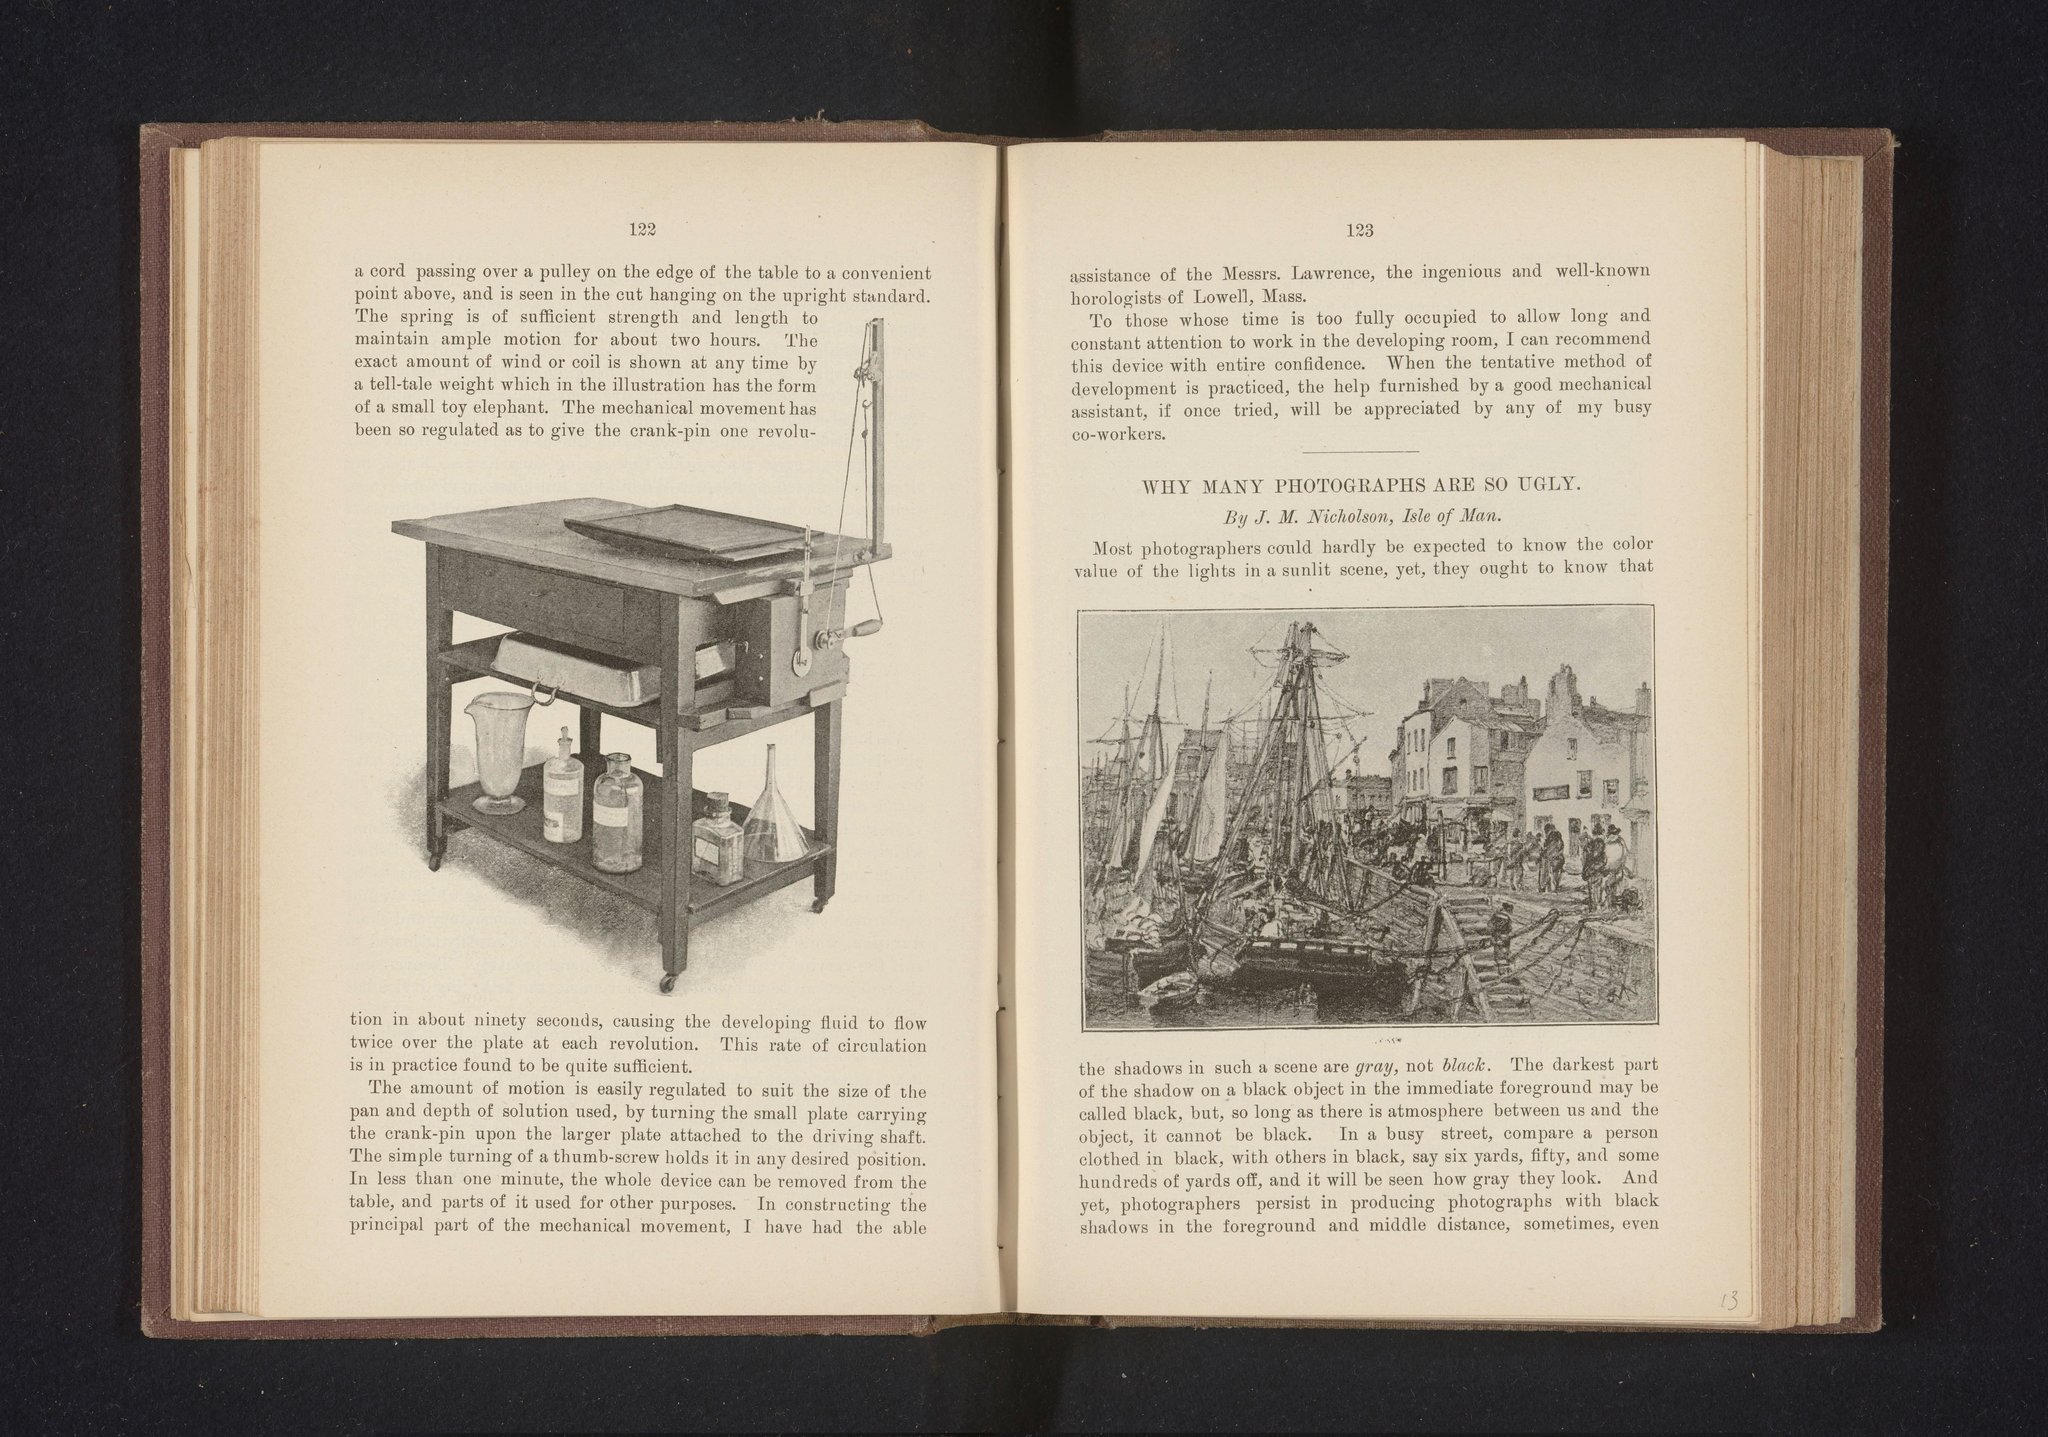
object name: page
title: Fotoreproductie van een tekening, voorstellende schepen in een haven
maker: Anonymous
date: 1888-1893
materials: paper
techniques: autotype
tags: harbour, ships (in general)